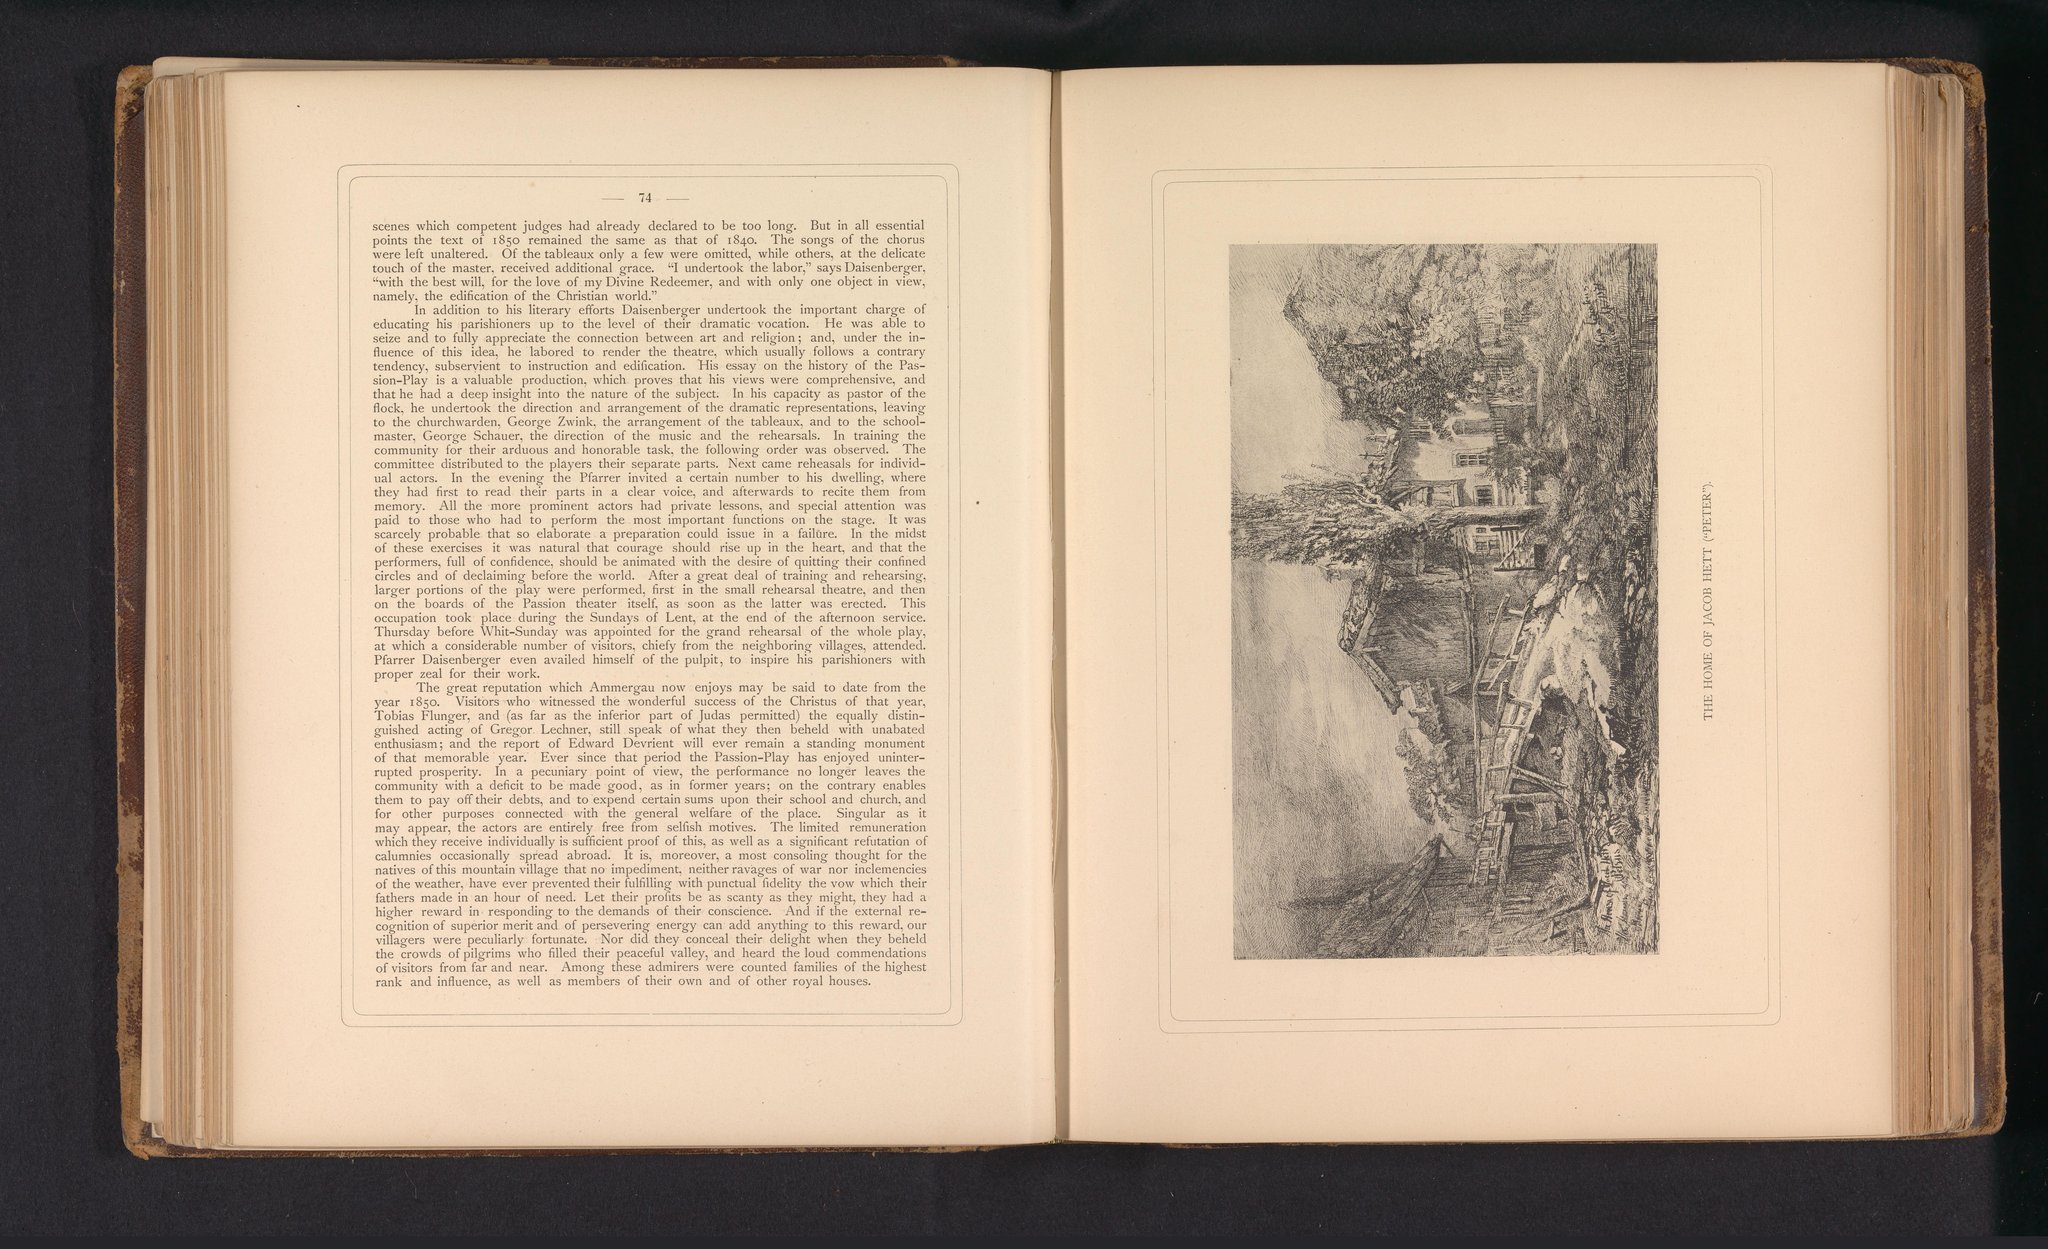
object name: reproduction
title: The home of Jacob Hett ("Peter")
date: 1871-1873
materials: paper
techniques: photograph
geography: oberammergau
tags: housing, façade (of house or building)